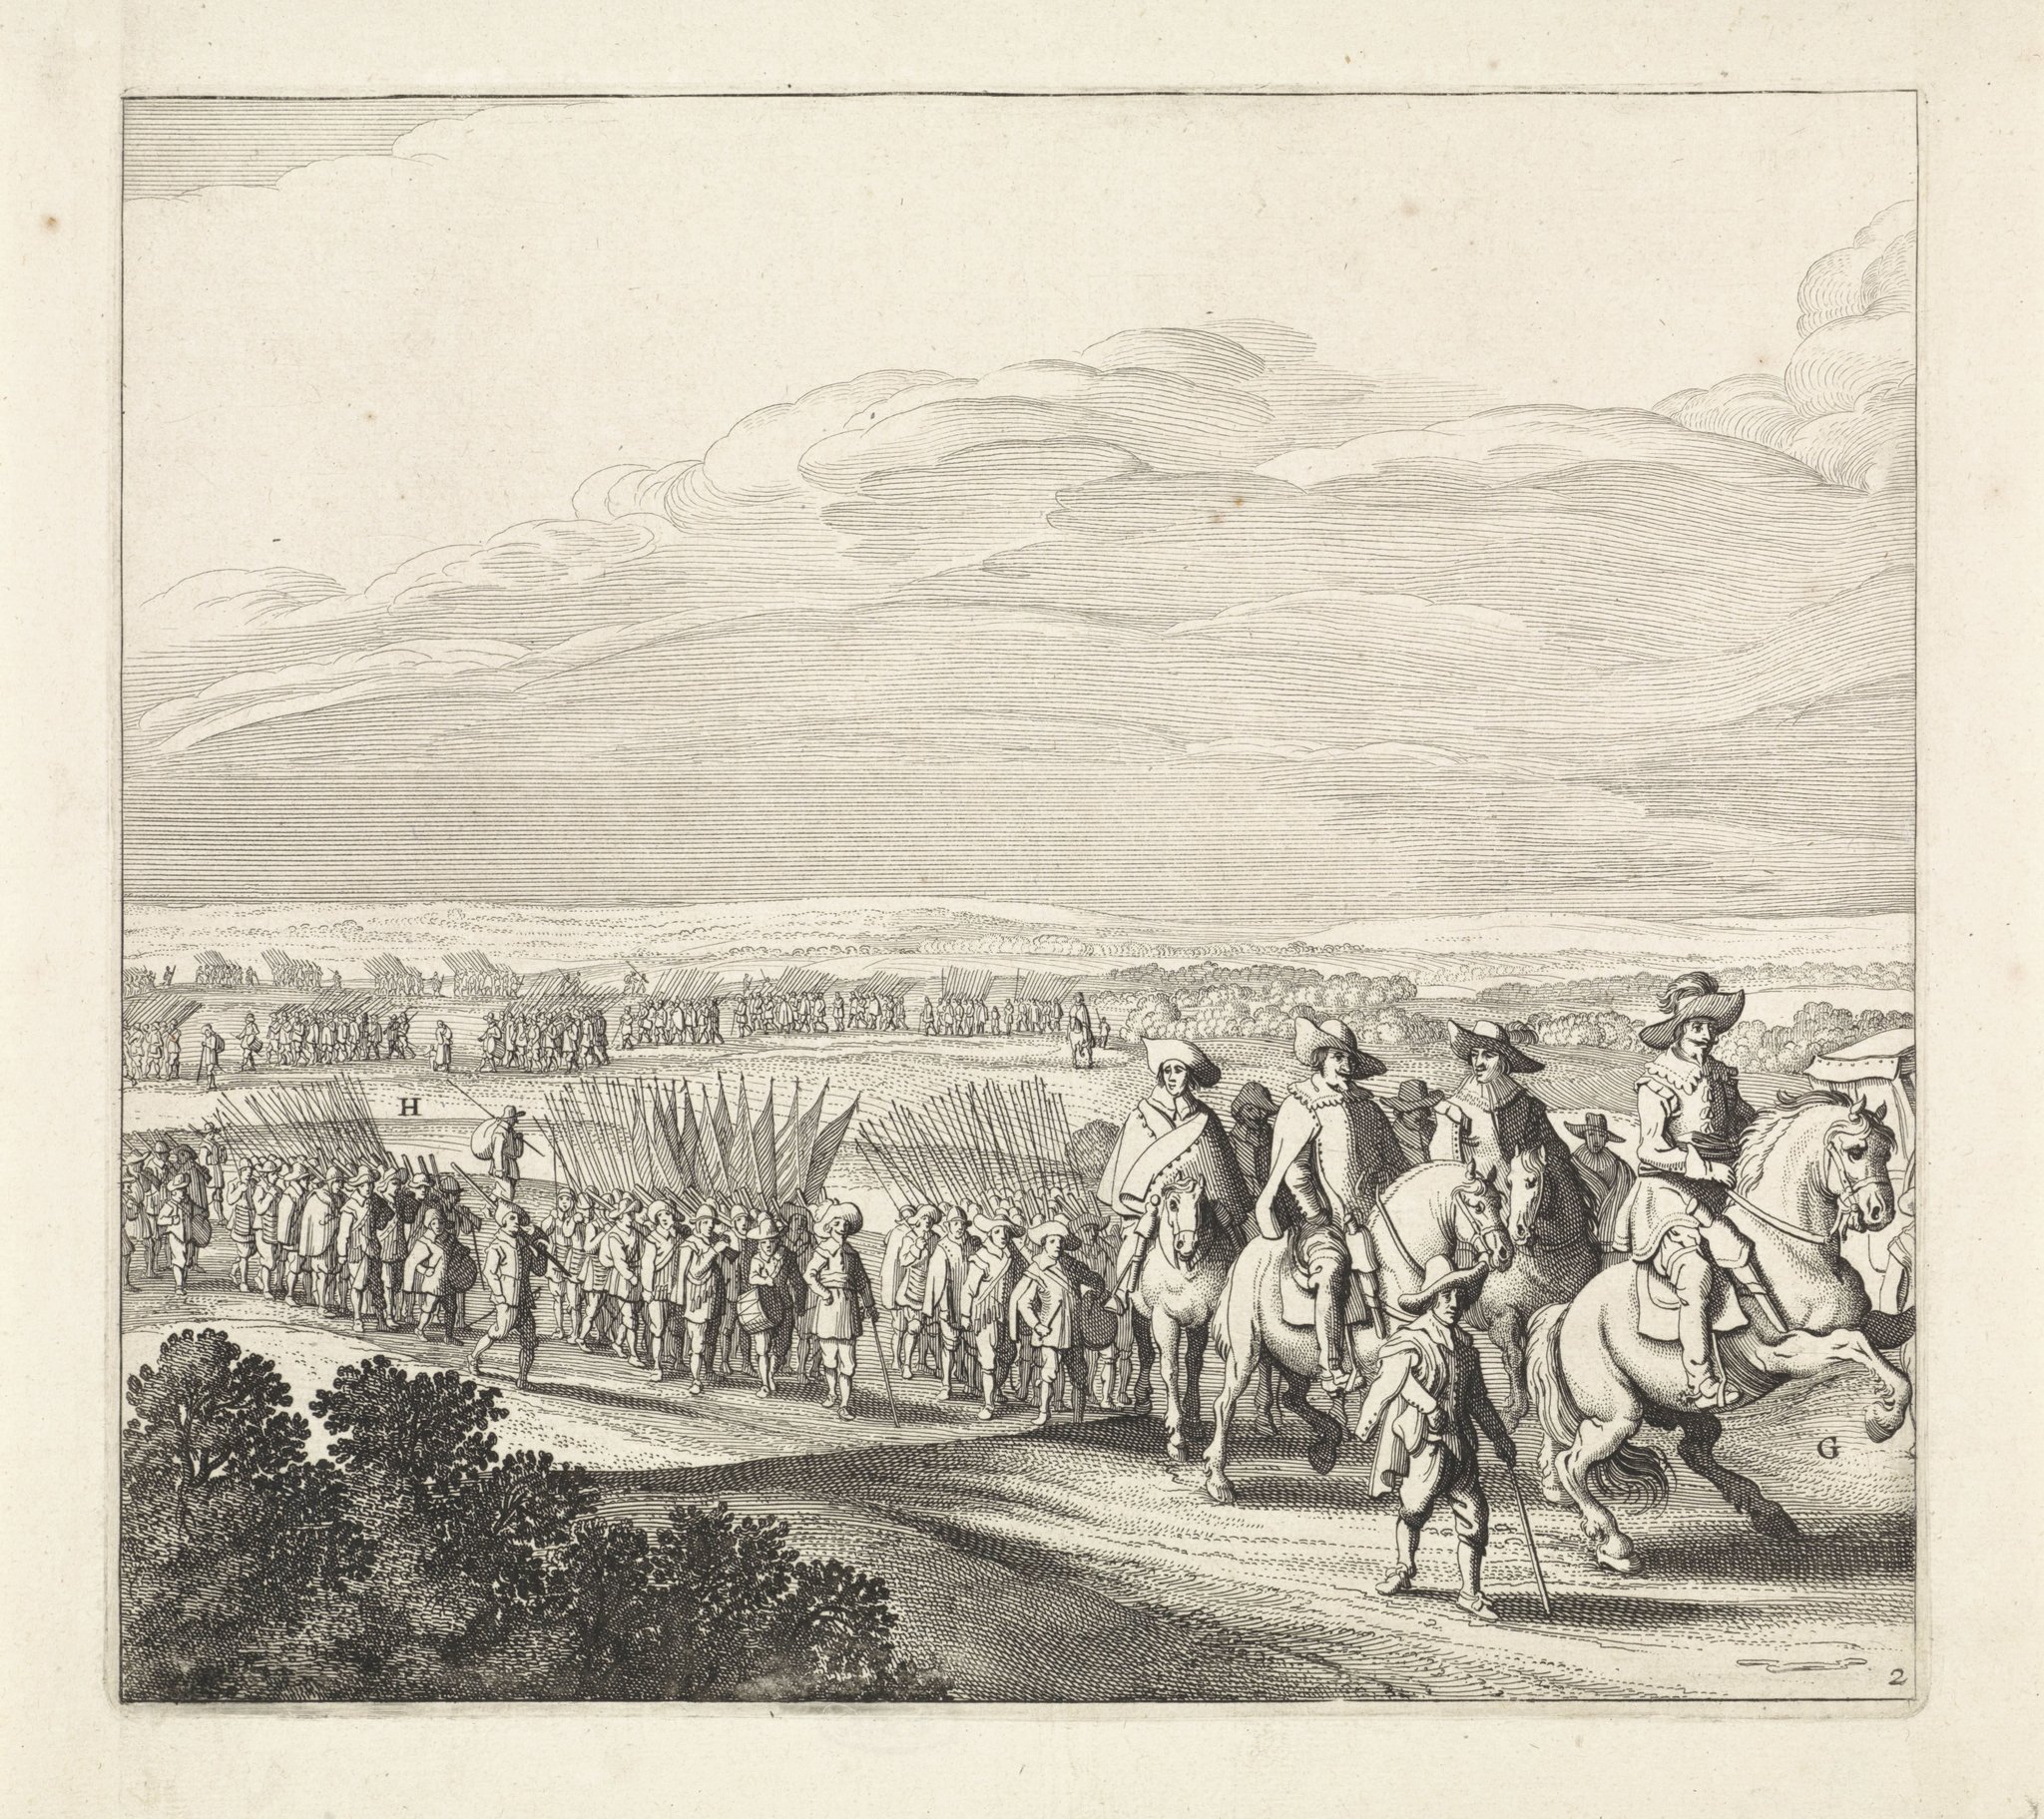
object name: print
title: Discessus Hispanici Praesidii Trajecti ad Mosam Ao. 1632. Die 23 Augusti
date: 1632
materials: paper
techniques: etching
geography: amsterdam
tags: retreat of the defeated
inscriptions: collector's mark: Lugt 964, number: ‘2’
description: Uittocht van het Spaanse leger uit Maastricht, 23 augustus 1632. Tweede prent uit een fries van zes genummerd prenten. De stoet van vertrekkende soldaten.